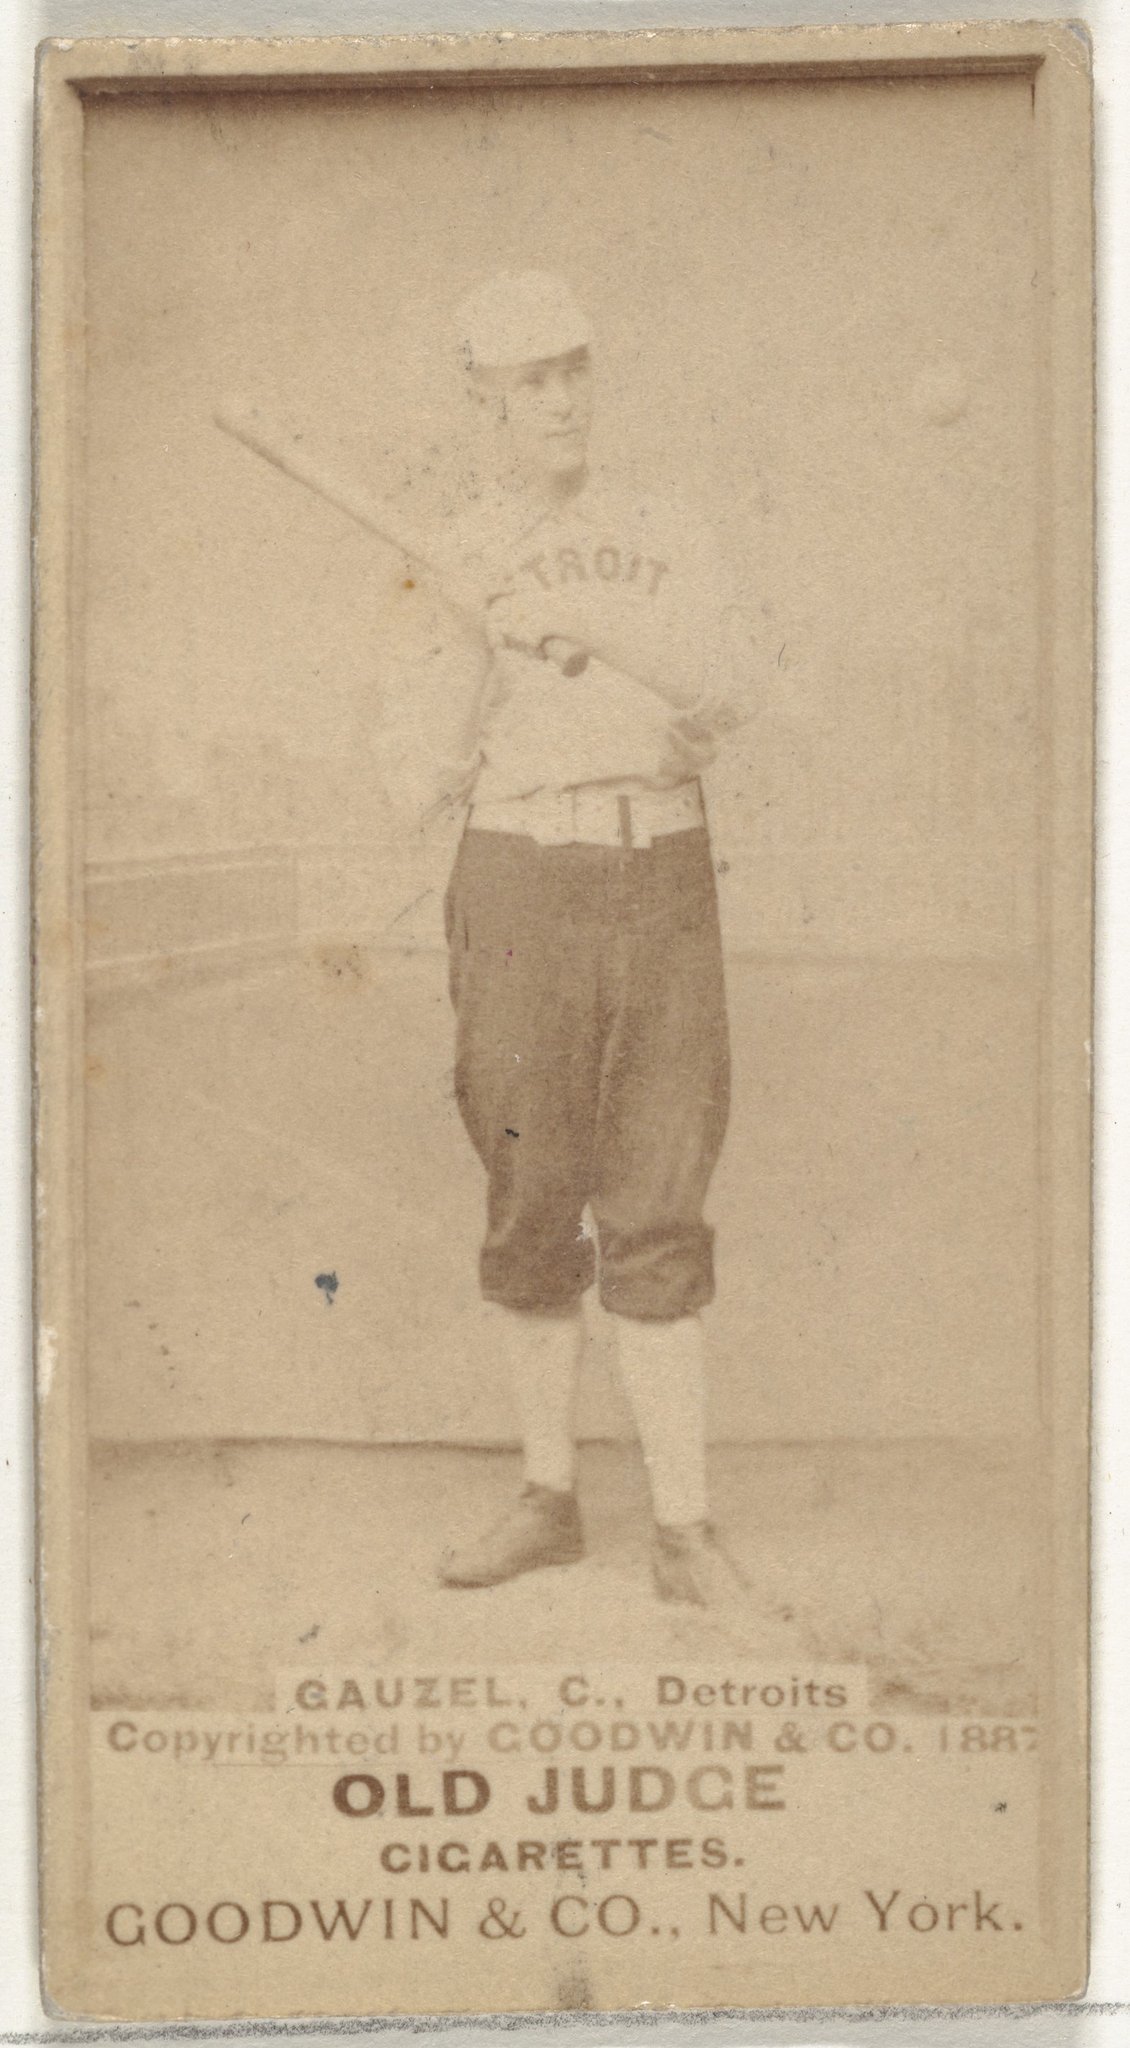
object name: baseball card, photograph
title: Charles William "Charlie" Ganzel, Catcher, Detroit Wolverines, from the Old Judge series (N172) for Old Judge Cigarettes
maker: goodwin & company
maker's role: publisher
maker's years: 1850-1950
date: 1887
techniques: albumen silver print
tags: men,portraits,baseball,athletes